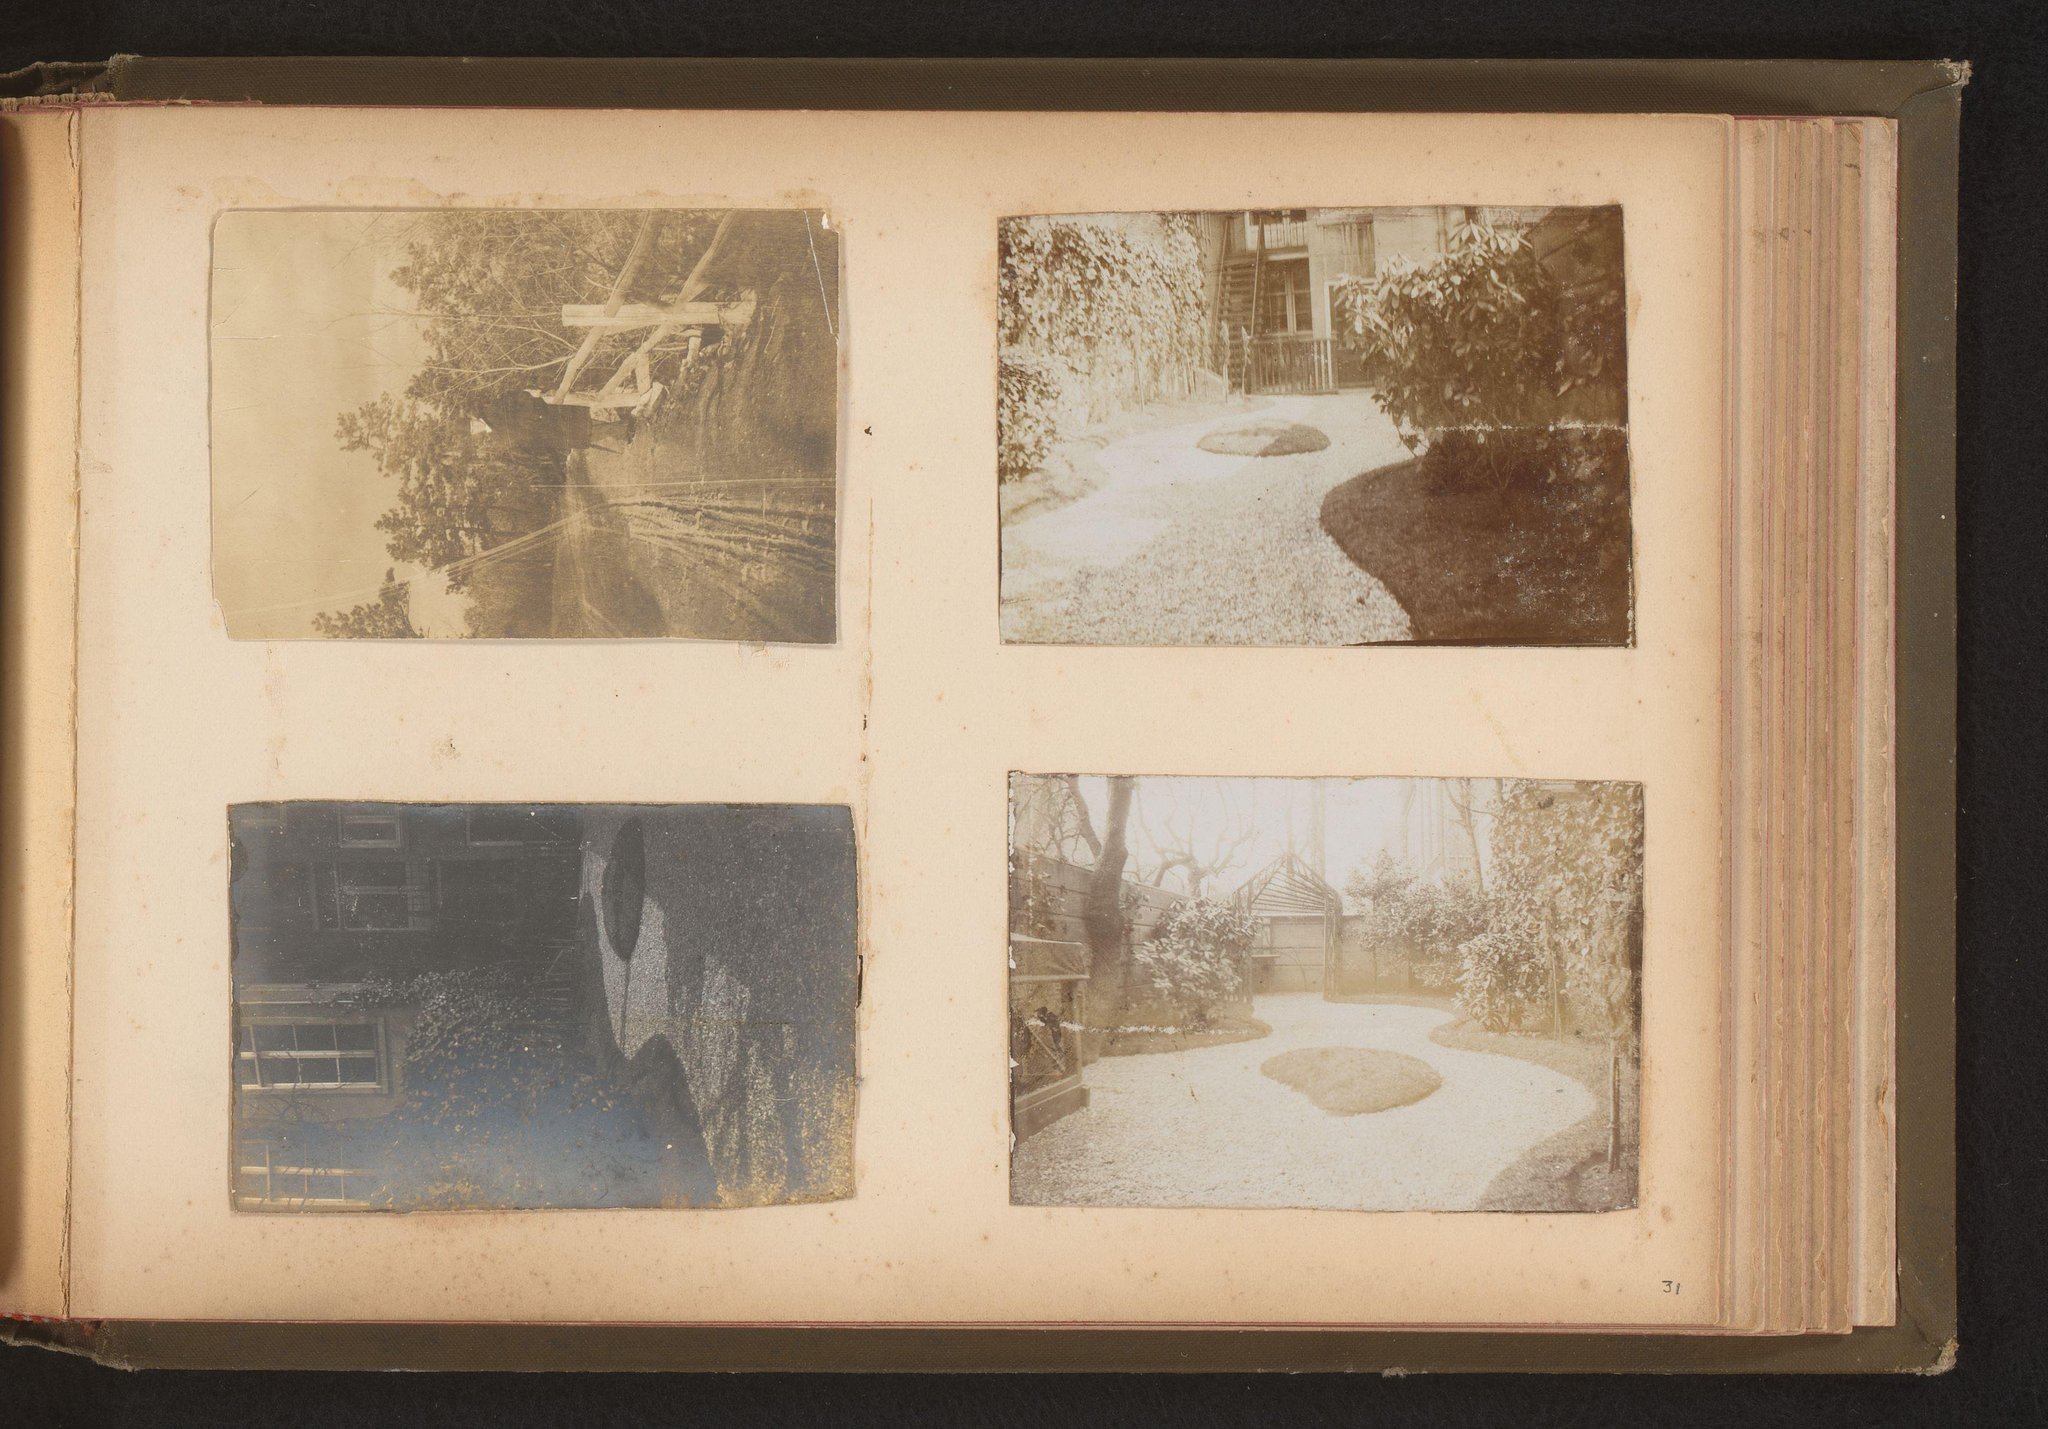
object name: photograph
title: Vier foto's van tuinen en parken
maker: Anonymous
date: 1895-1910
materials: paper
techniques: albumen print, gelatin silver print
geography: netherlands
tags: adult man, public gardens, park, netherlands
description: Deze foto's maken deel uit van een album.